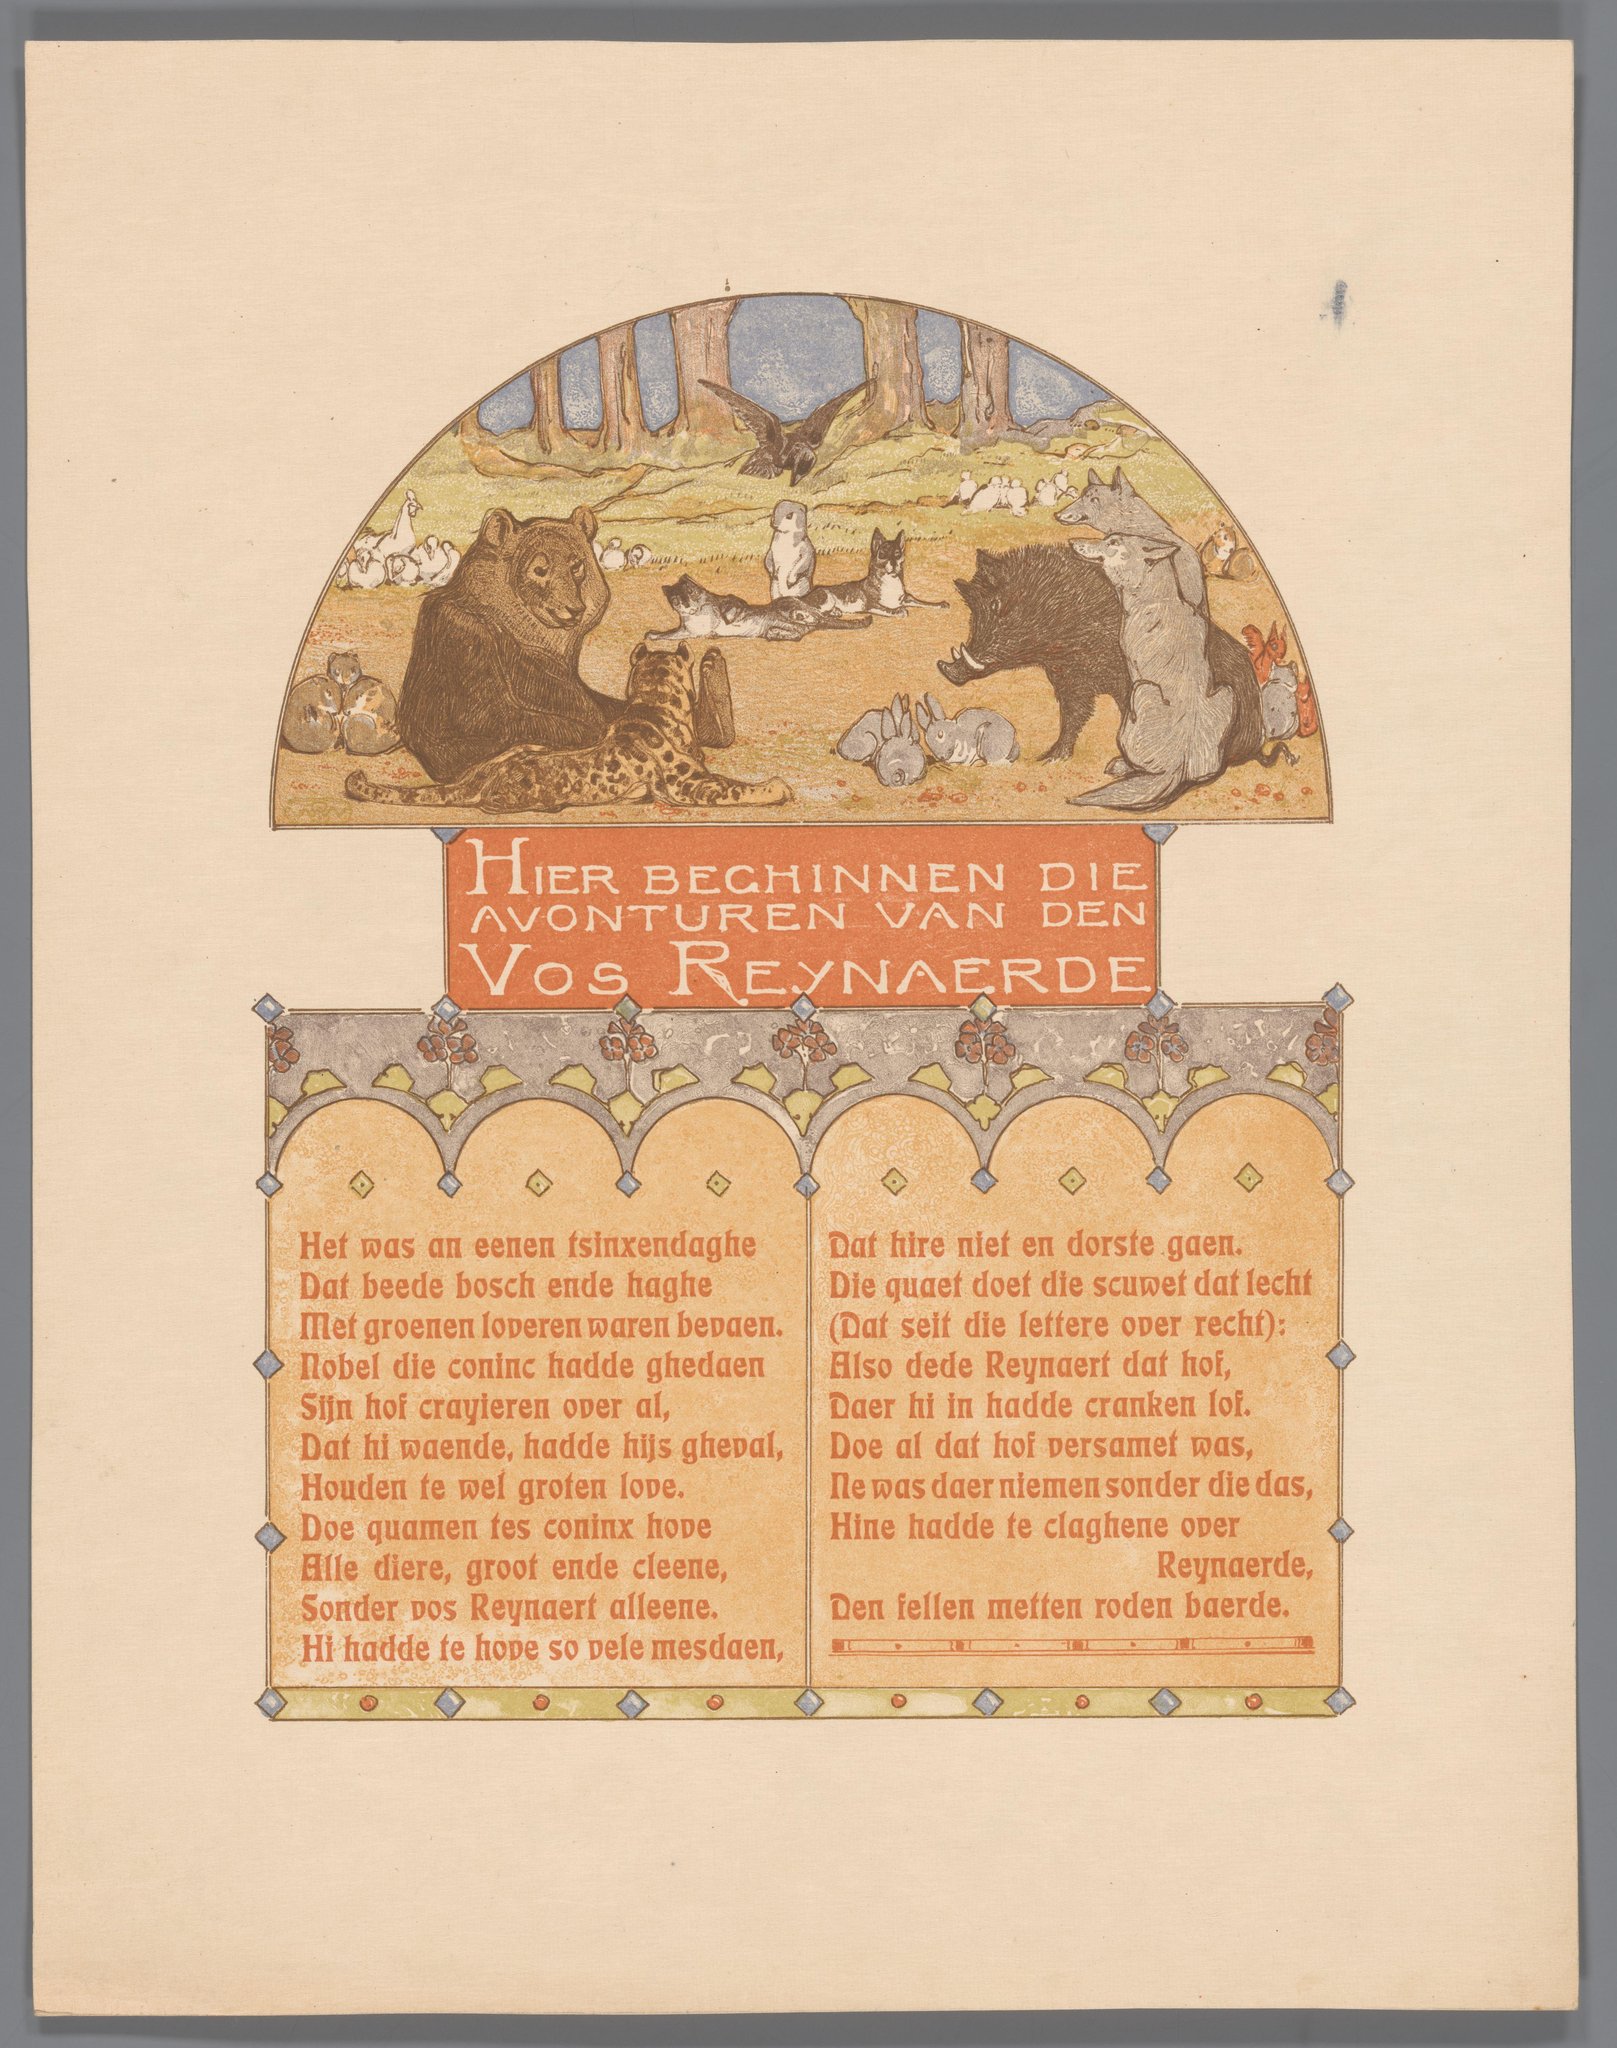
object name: book illustration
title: Groep dieren uit Reinaert de Vos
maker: bernard willem wierink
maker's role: draughtsman, print maker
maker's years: 1856-1939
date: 1910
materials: paper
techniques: lithograph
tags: fable of reynard the fox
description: Prent gebruikt in: Streuvels, Stijn (Frank Lateur). Reinaert de Vos naar verschillende uitgaven van het middeleeuwsche epos. Amsterdam: L.J. Veen, 1910.